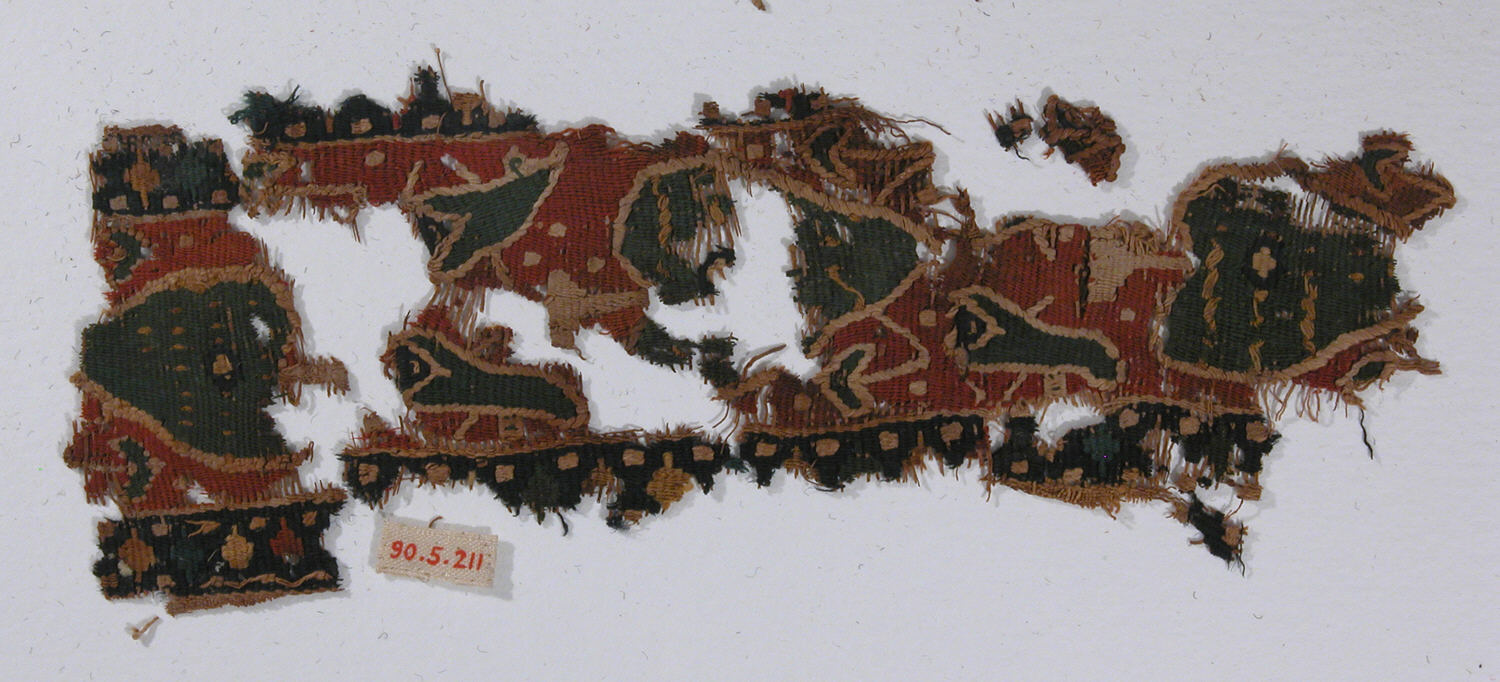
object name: textile fragment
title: Fragment of Shoulder Band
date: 401-600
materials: linen, wool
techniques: weave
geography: egypt